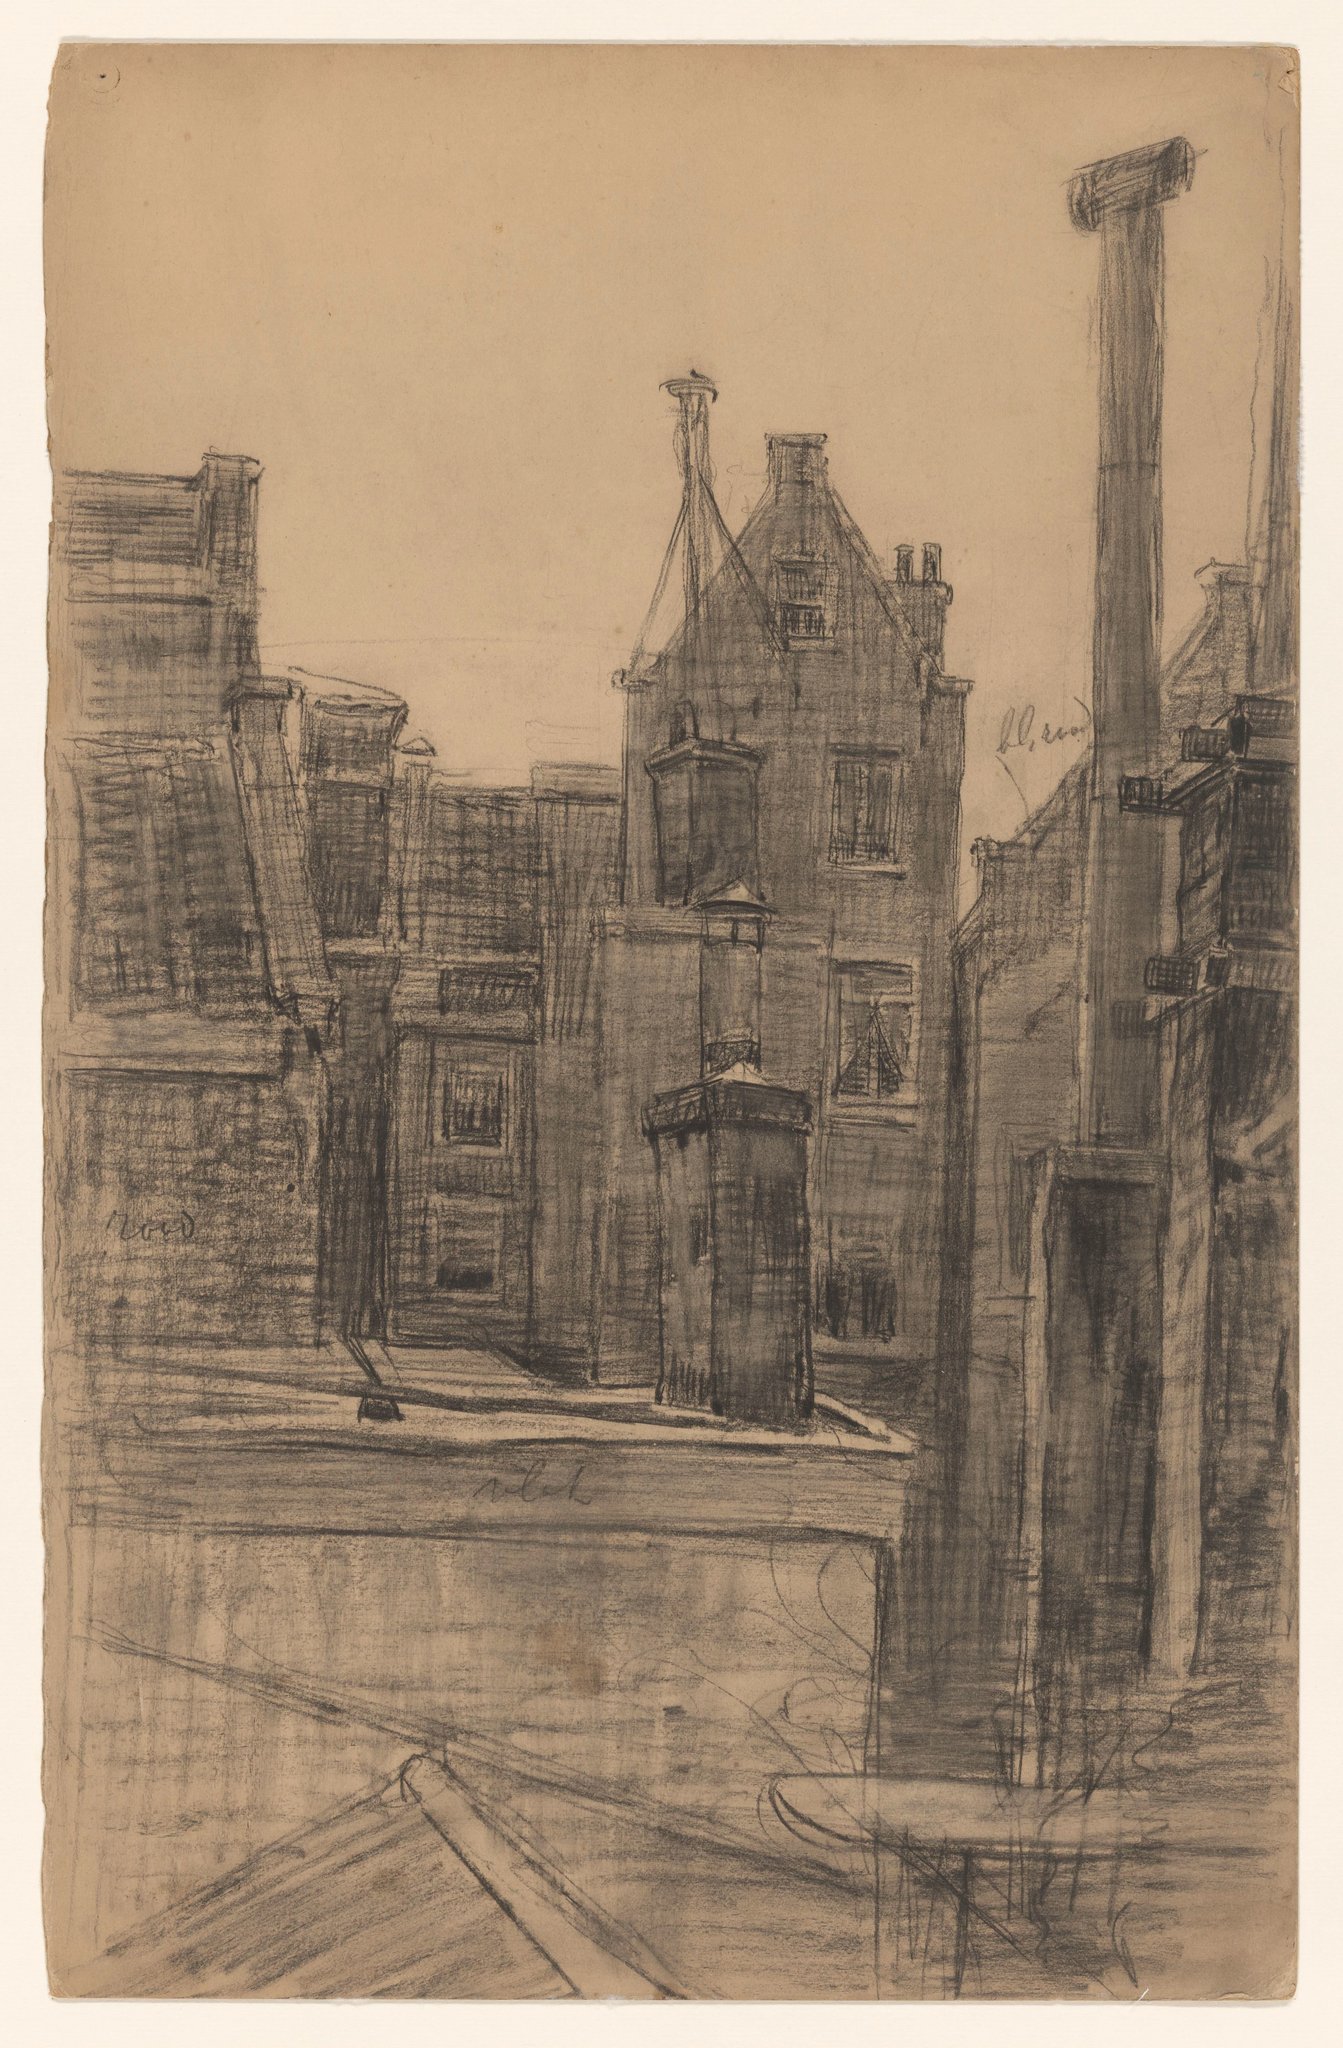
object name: drawing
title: Gezicht op de achterkant van huizen, met kleurnotities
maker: wilhelmus johannes steenhoff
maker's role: draughtsman, print maker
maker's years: 1863-1932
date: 1873-1932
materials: cardboard, chalk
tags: public road